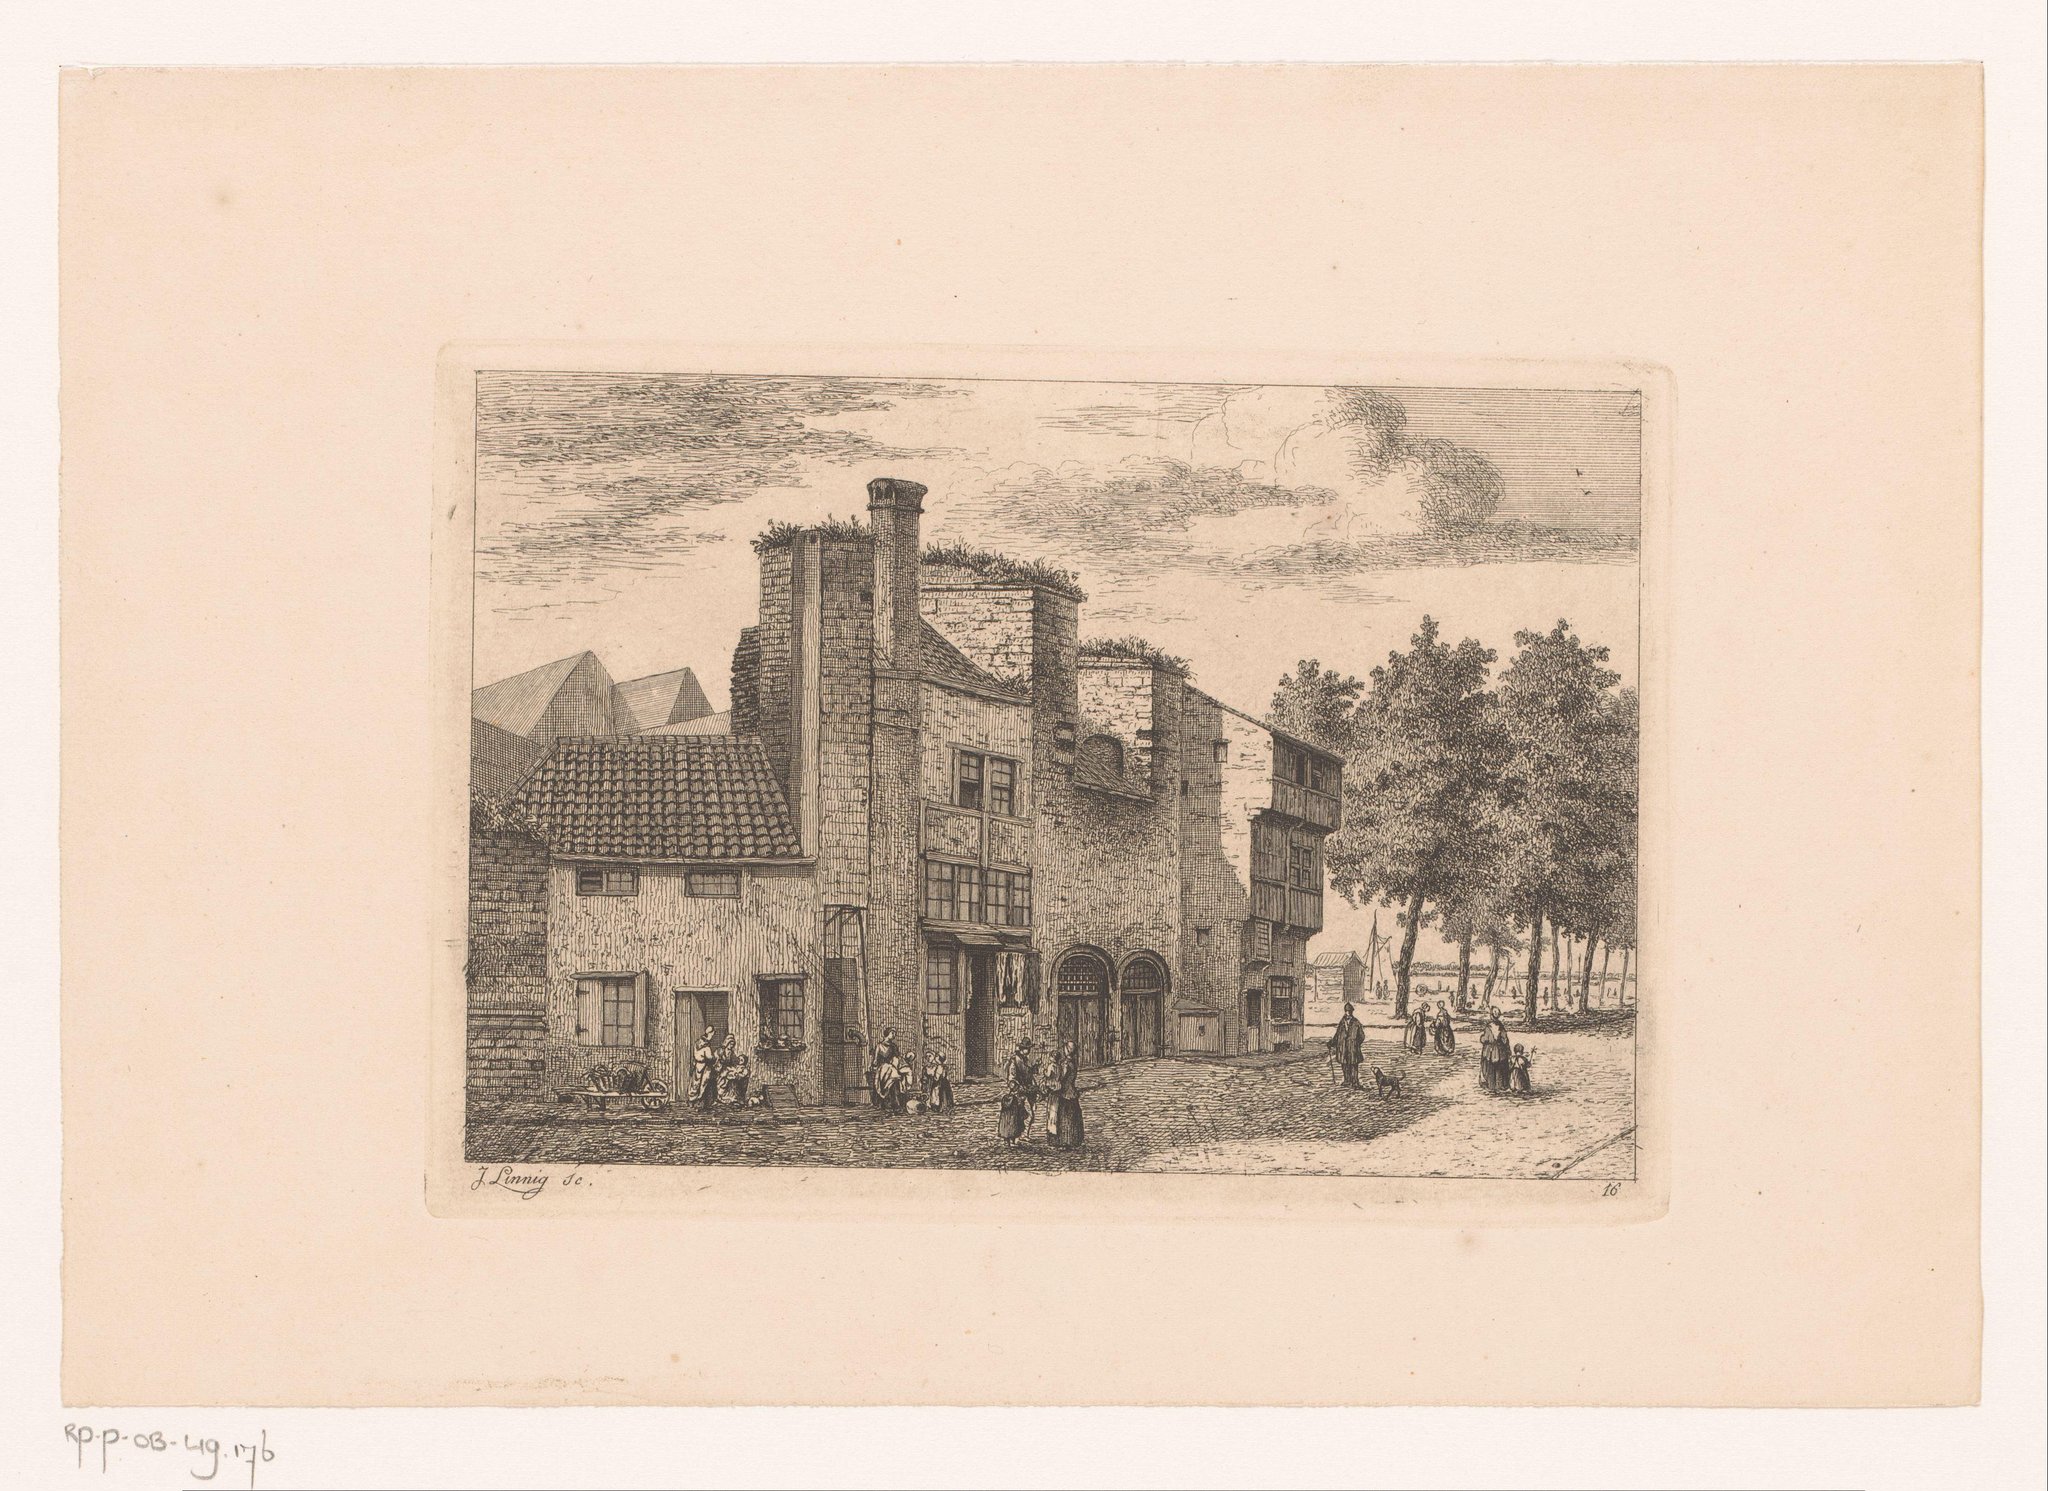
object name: print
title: Overblijfselen van het koor van de Sint-Walburgiskerk in Antwerpen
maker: jean théodore joseph linnig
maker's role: draughtsman, print maker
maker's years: 1815-1891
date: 1868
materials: paper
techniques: etching, intaglio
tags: façade (of house or building)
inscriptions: collector's mark: Lugt 2228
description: Prent uit: Mertens, F.H. Album historique de la ville d'Anvers [...]. Antwerpen: J.E. Buschmann, 1868.